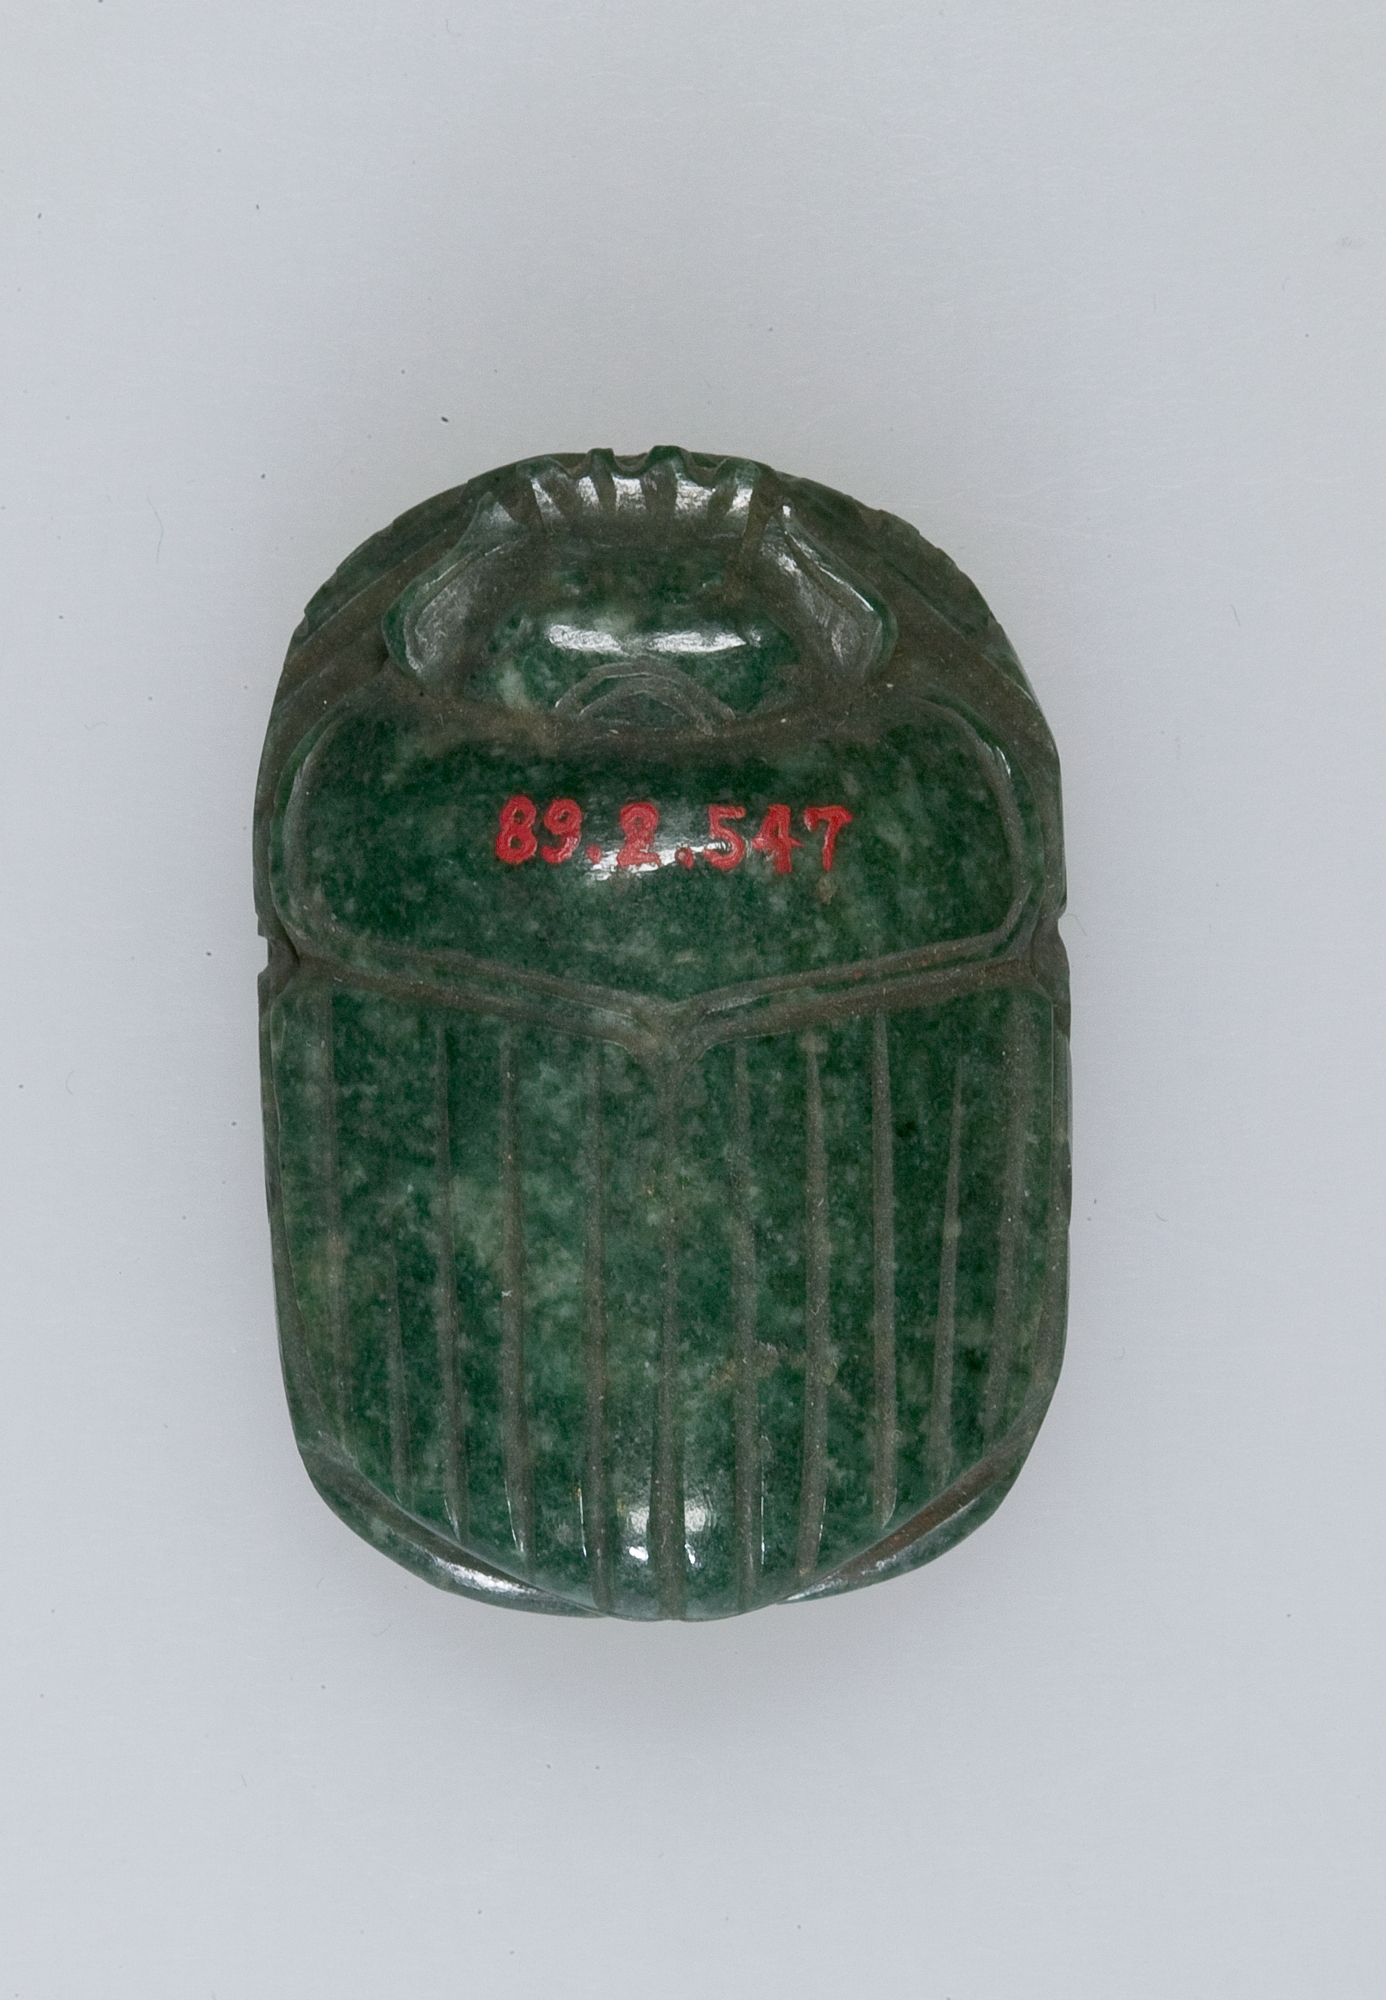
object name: heart scarab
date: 1550-1186 BCE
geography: egypt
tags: scarabs